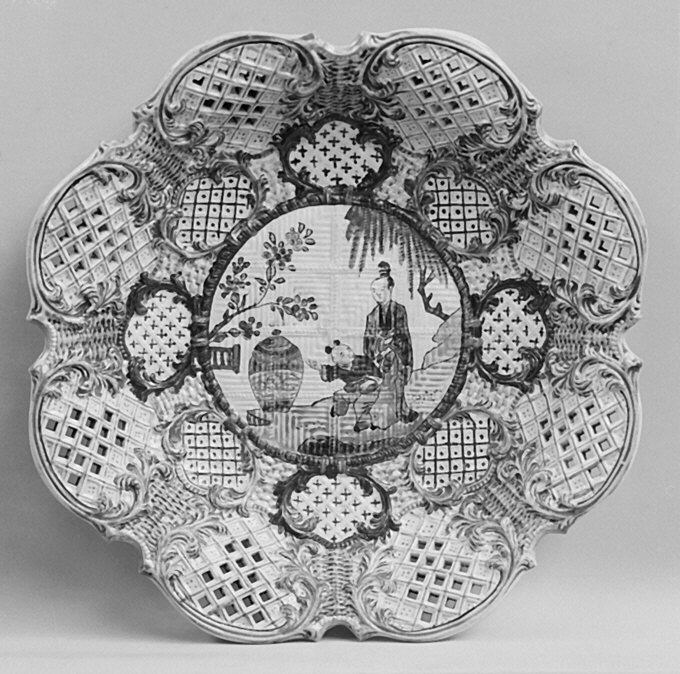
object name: dish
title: Pierced dish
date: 1760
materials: stoneware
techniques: salt glaze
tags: human figures,chinoiserie